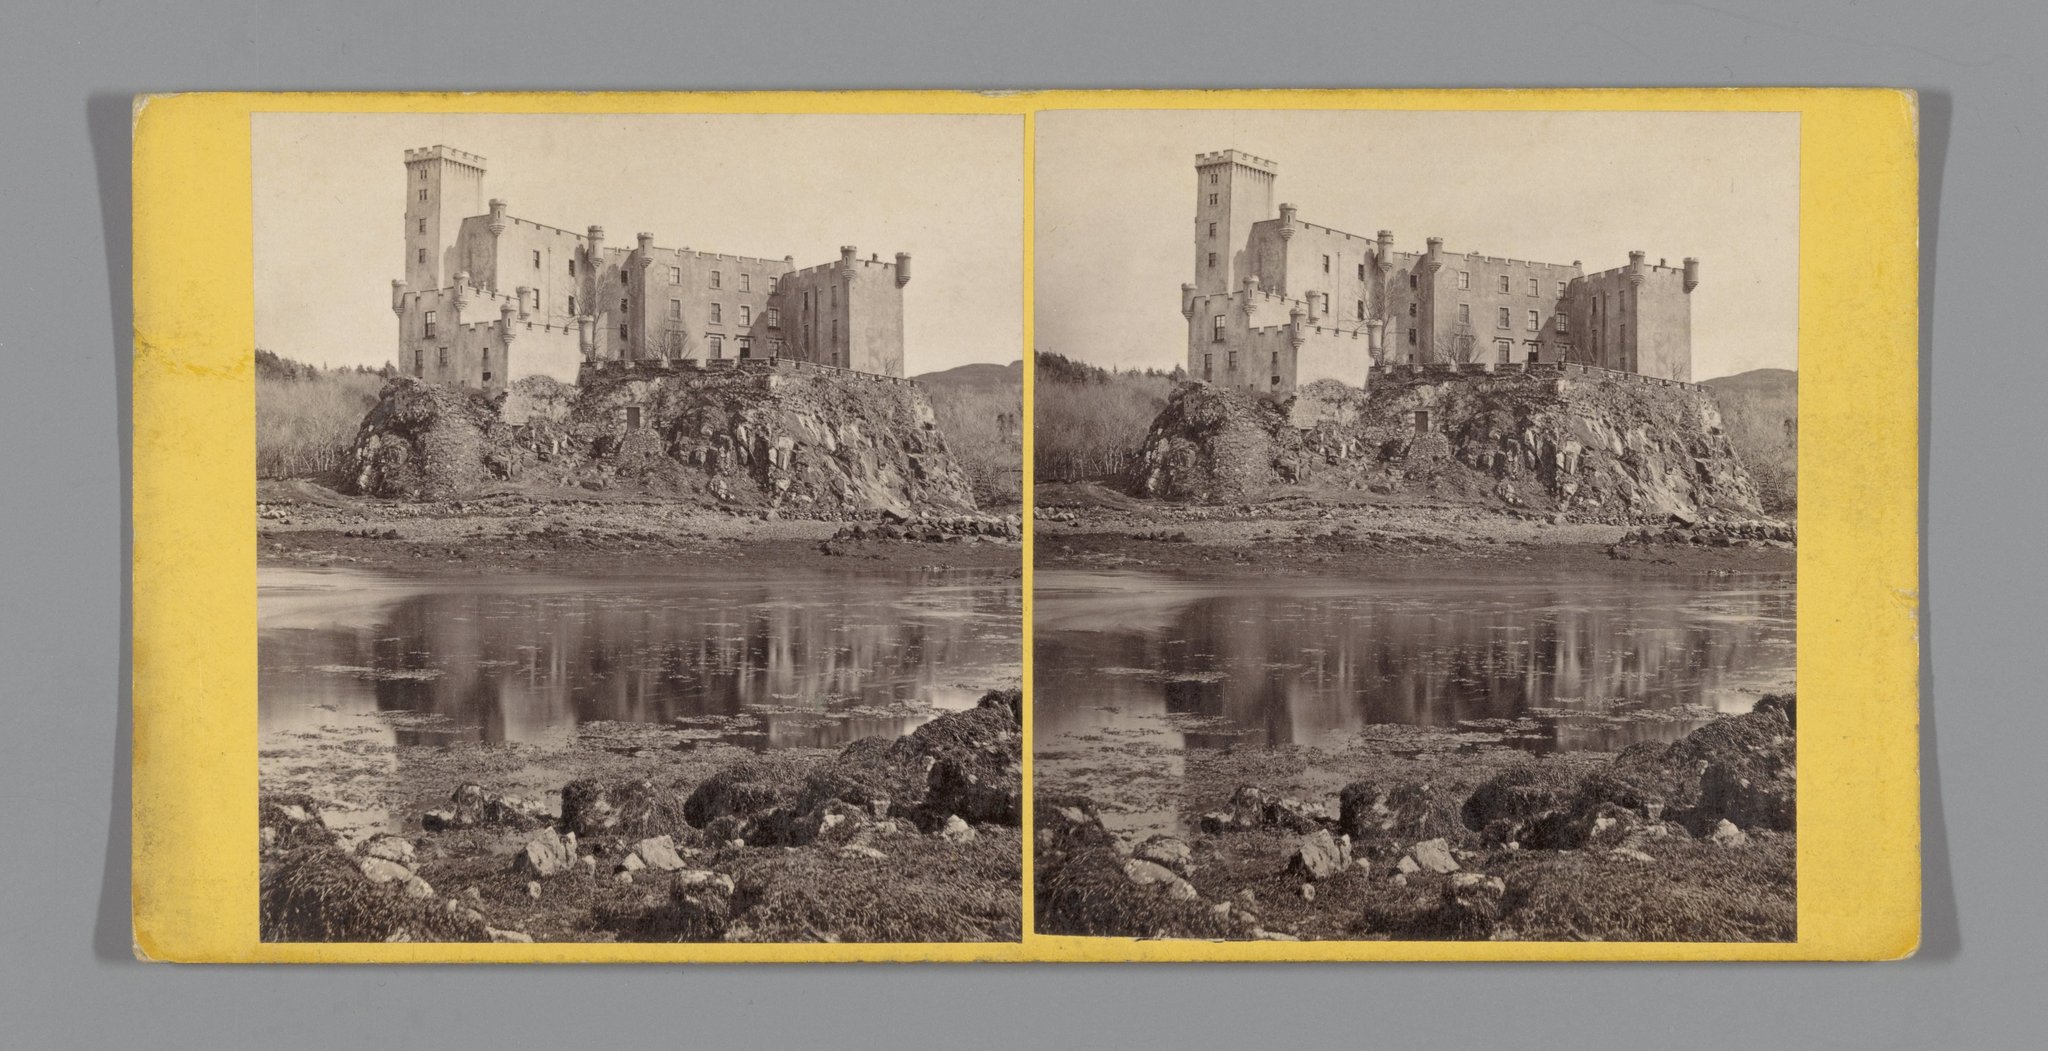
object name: stereograph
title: Dunvegan Castle-Skye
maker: george washington wilson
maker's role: publisher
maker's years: 1823-1893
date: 1850-1880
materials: cardboard, photographic support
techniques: albumen print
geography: skye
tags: castle, façade (of house or building)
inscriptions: name: ‘Registered G. W. Wilson, Photographer, Aberdeen’, number: ‘No. 248.’